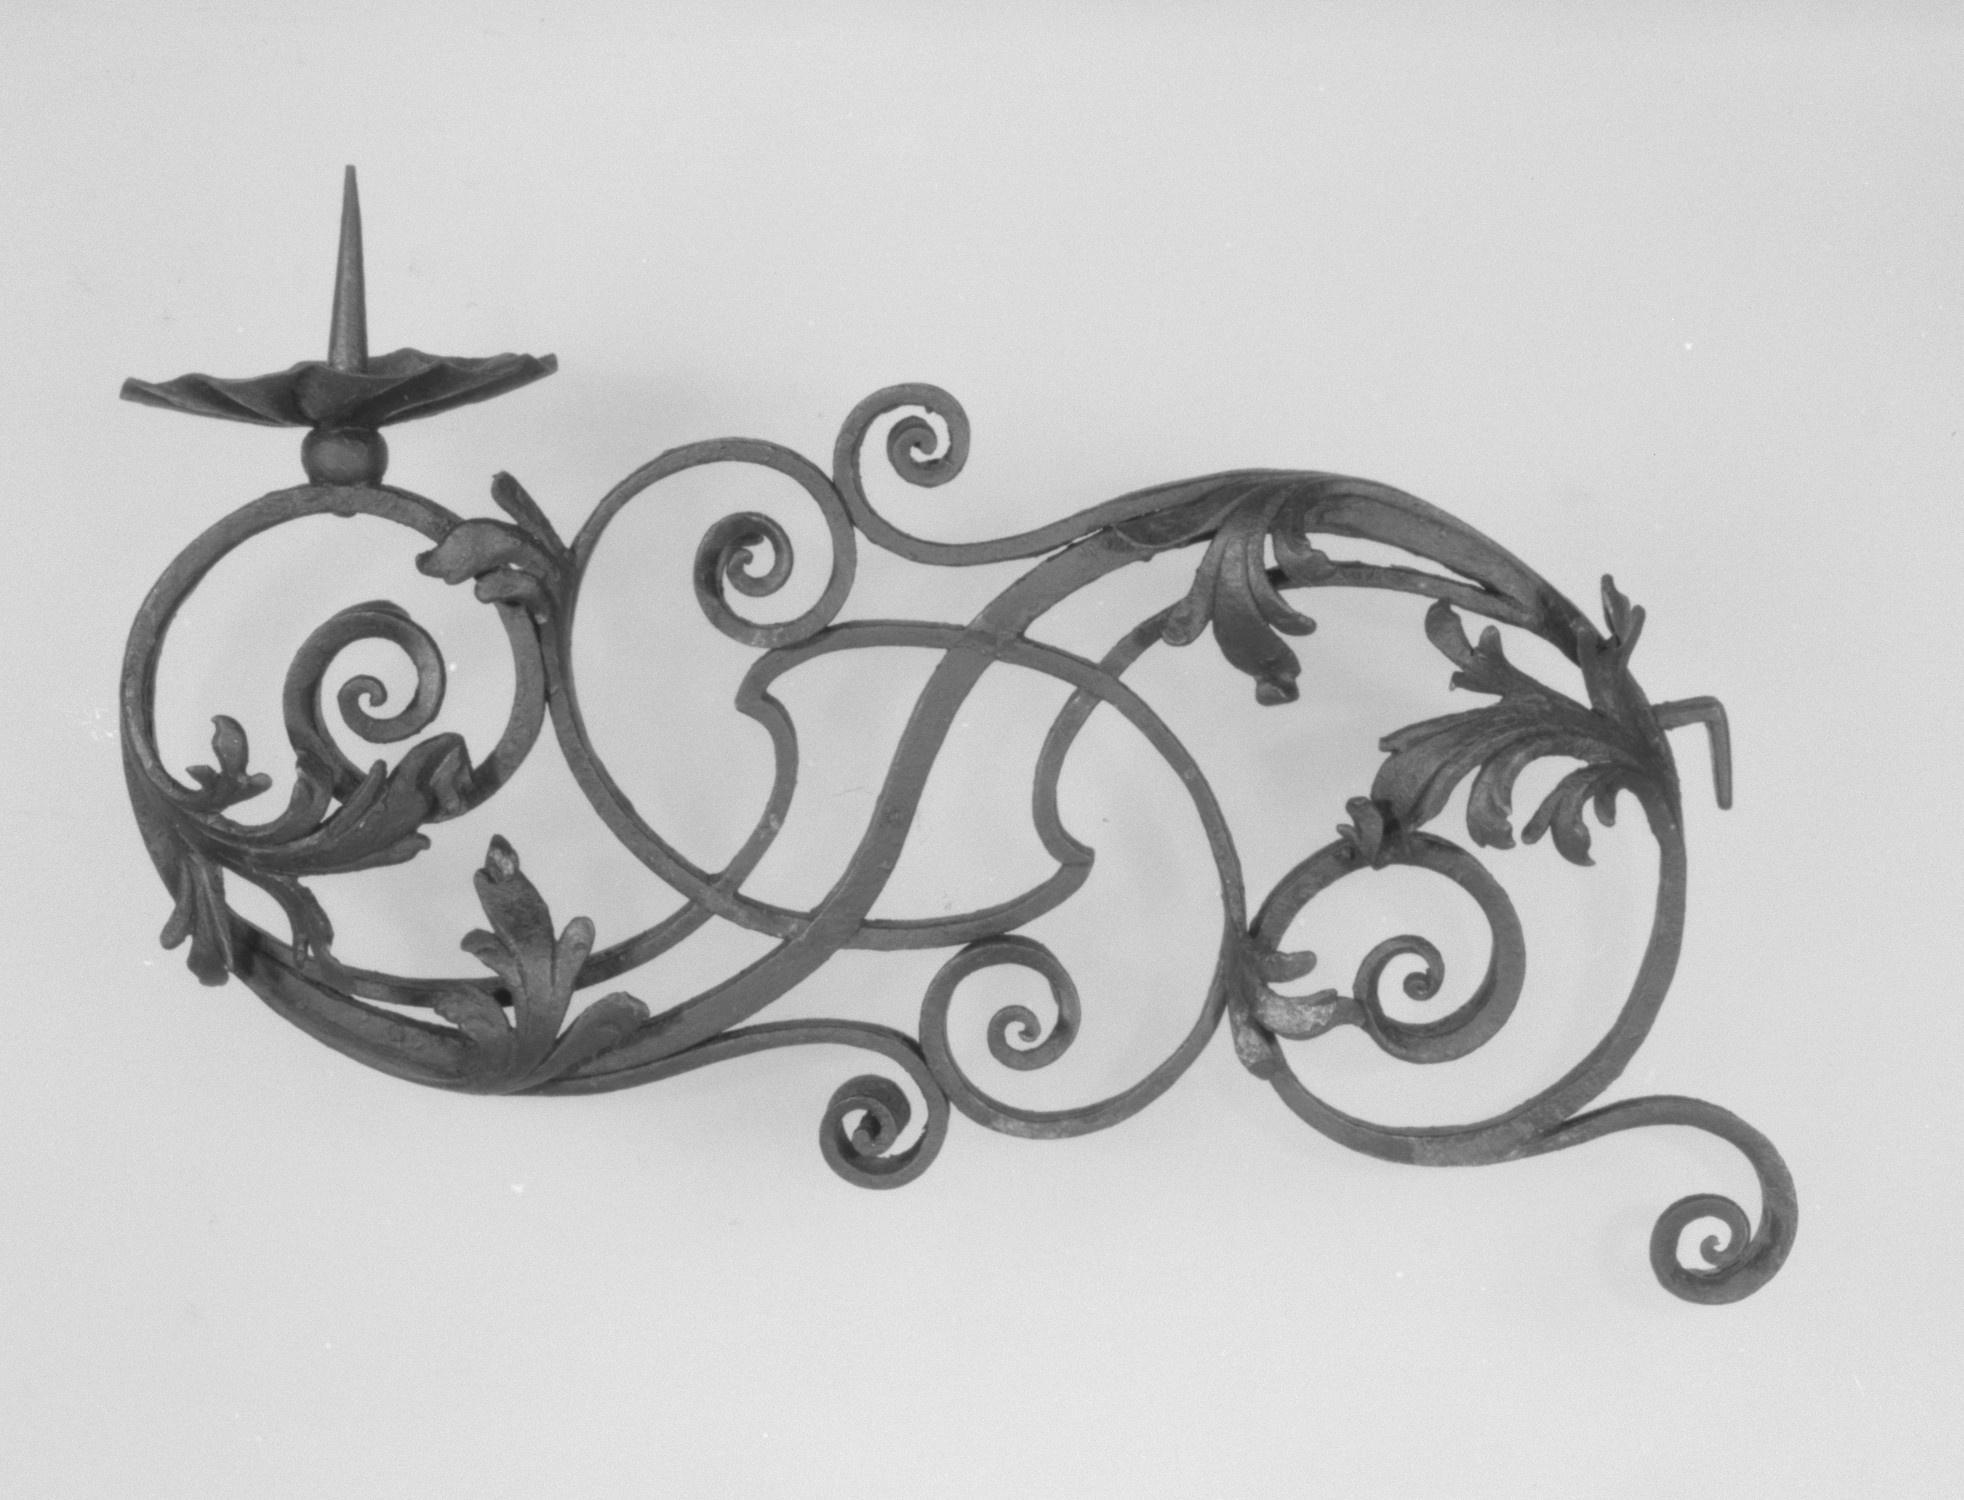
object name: sconce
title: Pair of sconces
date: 1701-1750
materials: iron